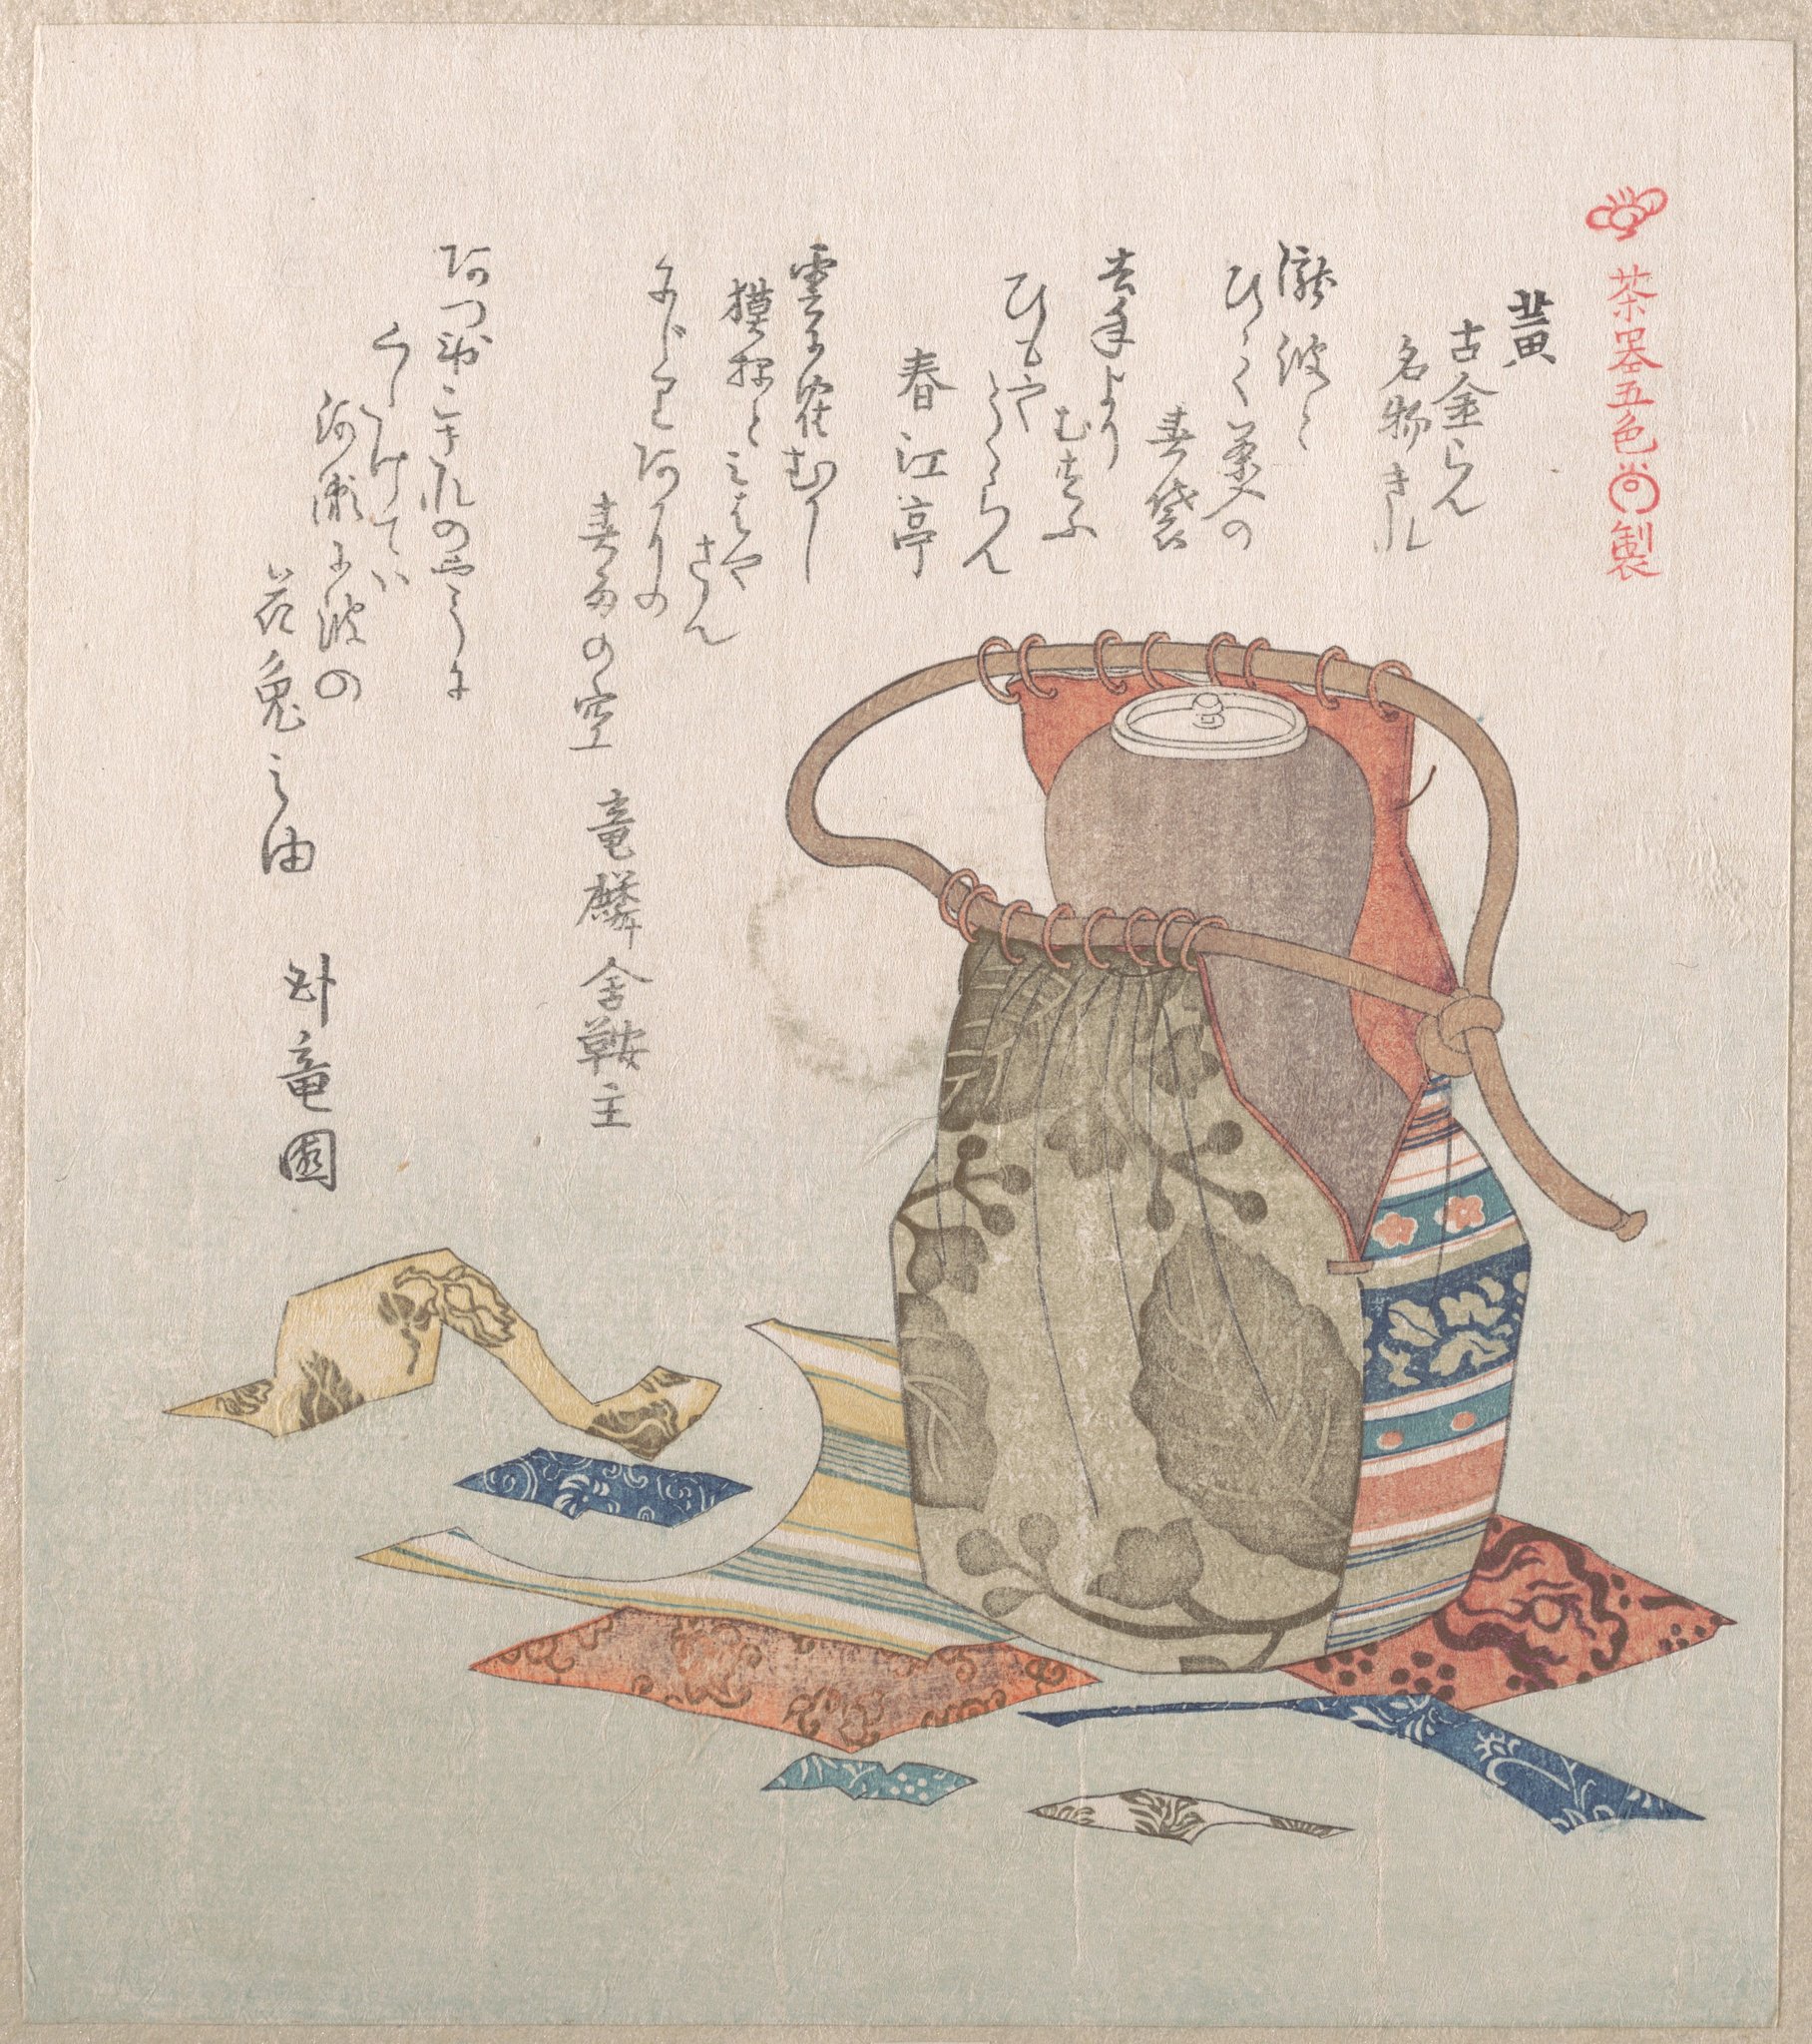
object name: print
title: Yellow; Tea Jar with Cover and Fragments of Brocade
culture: japanese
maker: kubo shunman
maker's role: artist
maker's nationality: japanese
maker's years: 1757-1820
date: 1801-1900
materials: ink, paper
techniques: surimono, woodblock print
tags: tea caddy